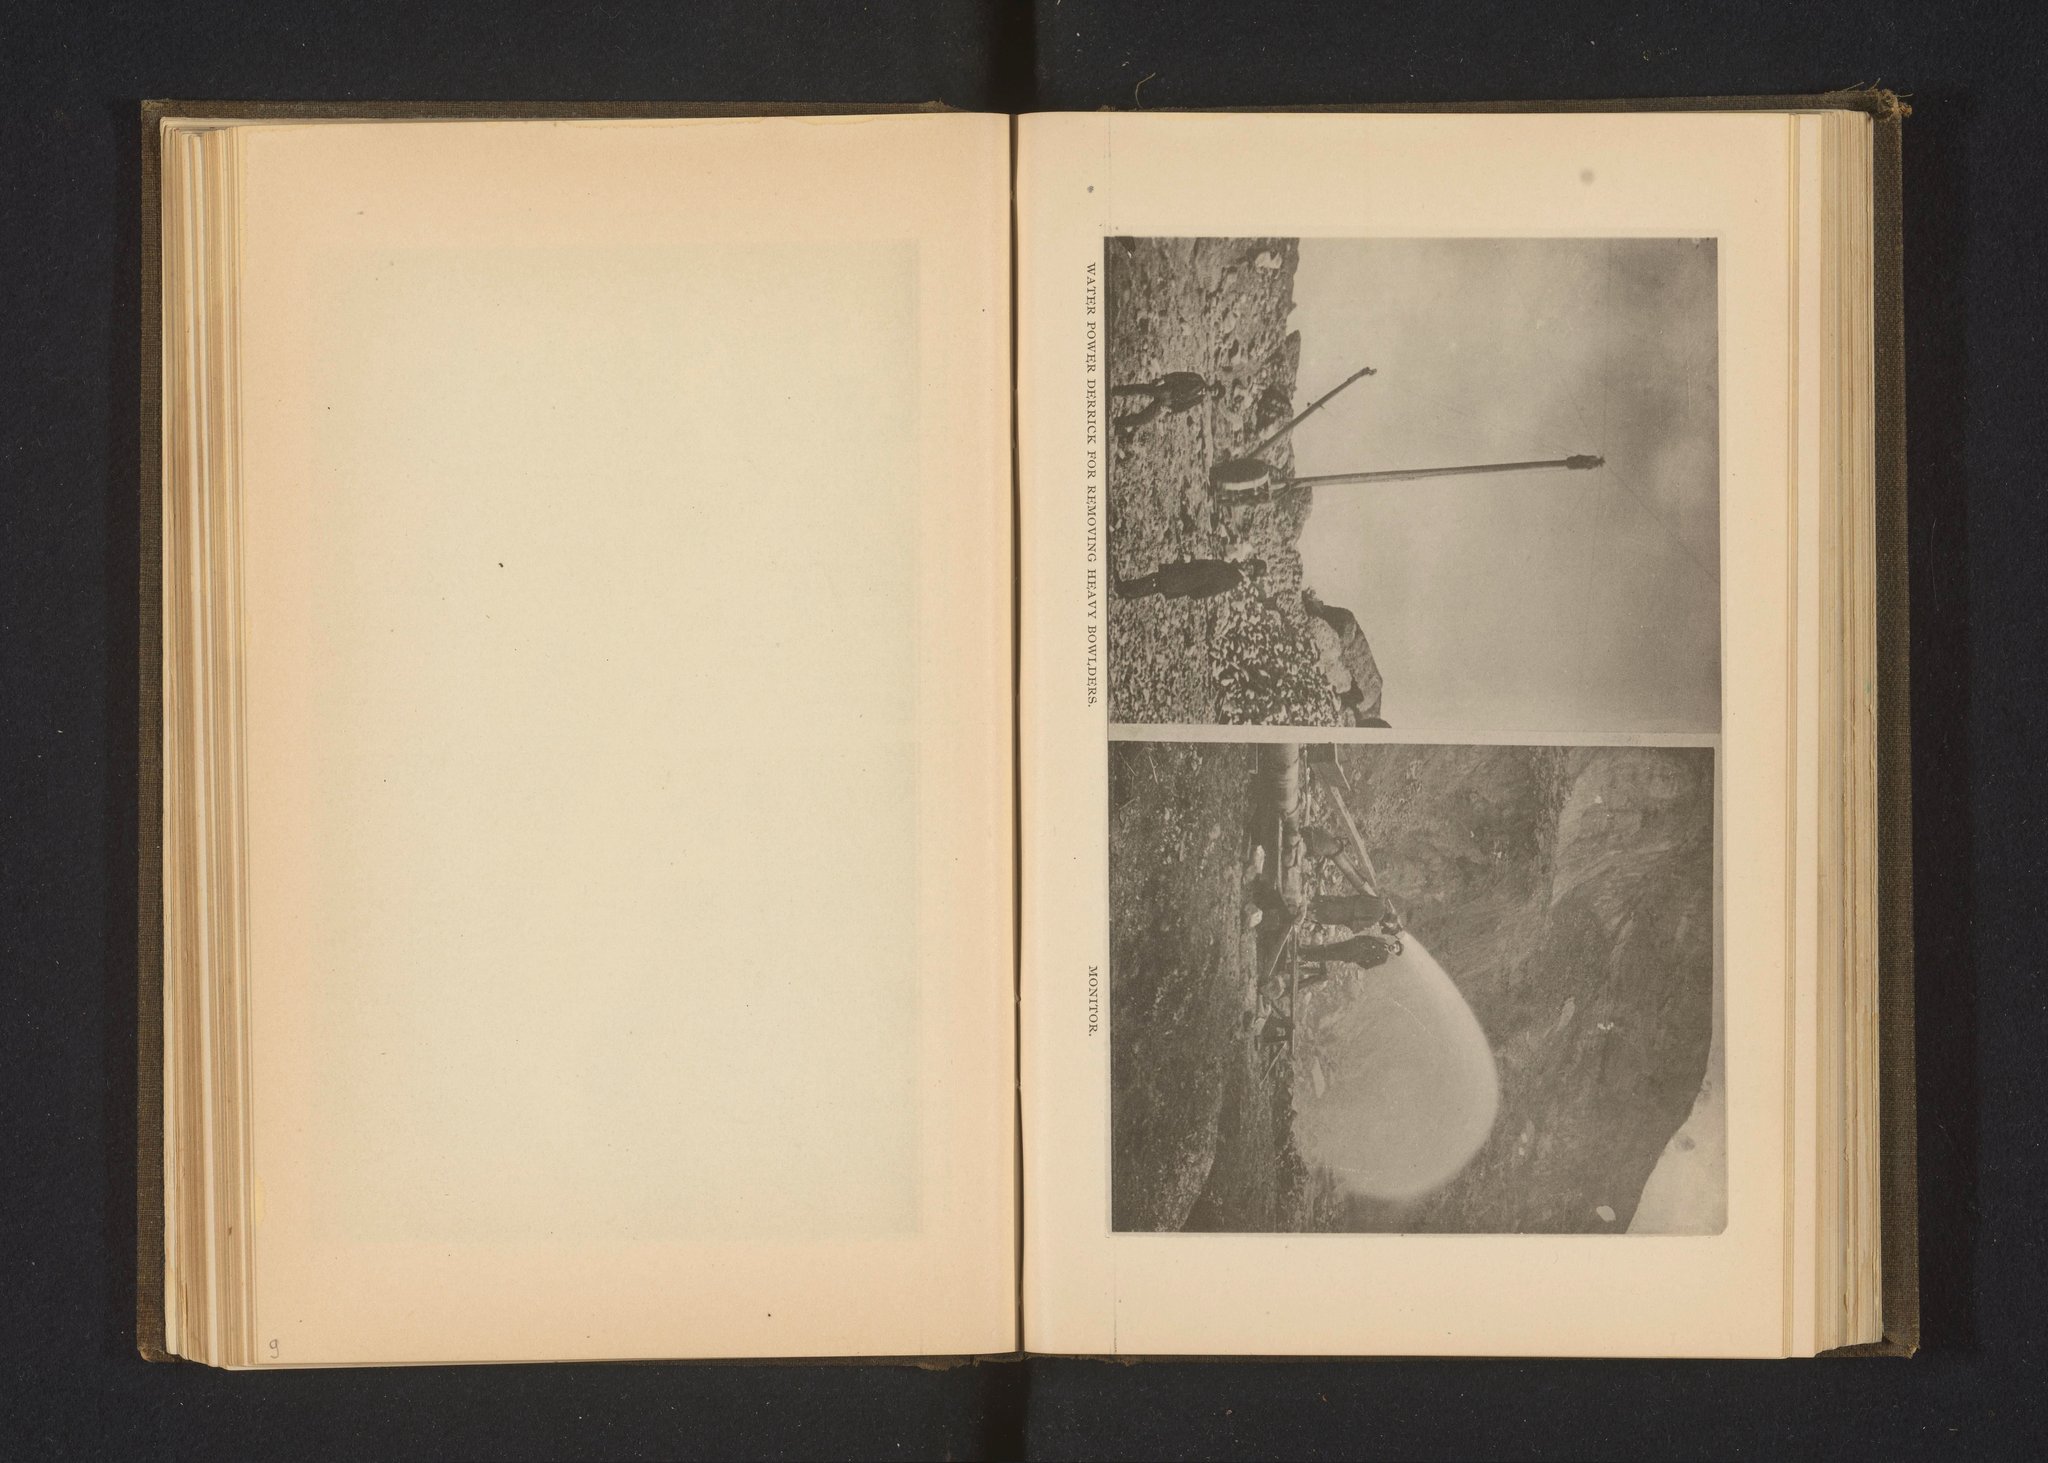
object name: page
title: Gezicht op een boortoren om grote rotsblokken te verwijderen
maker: Anonymous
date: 1885-1890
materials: paper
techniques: photograph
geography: california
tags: boring, drilling, piercing (industrial processes), mine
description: Prent op tweede ongenummerde pagina na pagina 126.